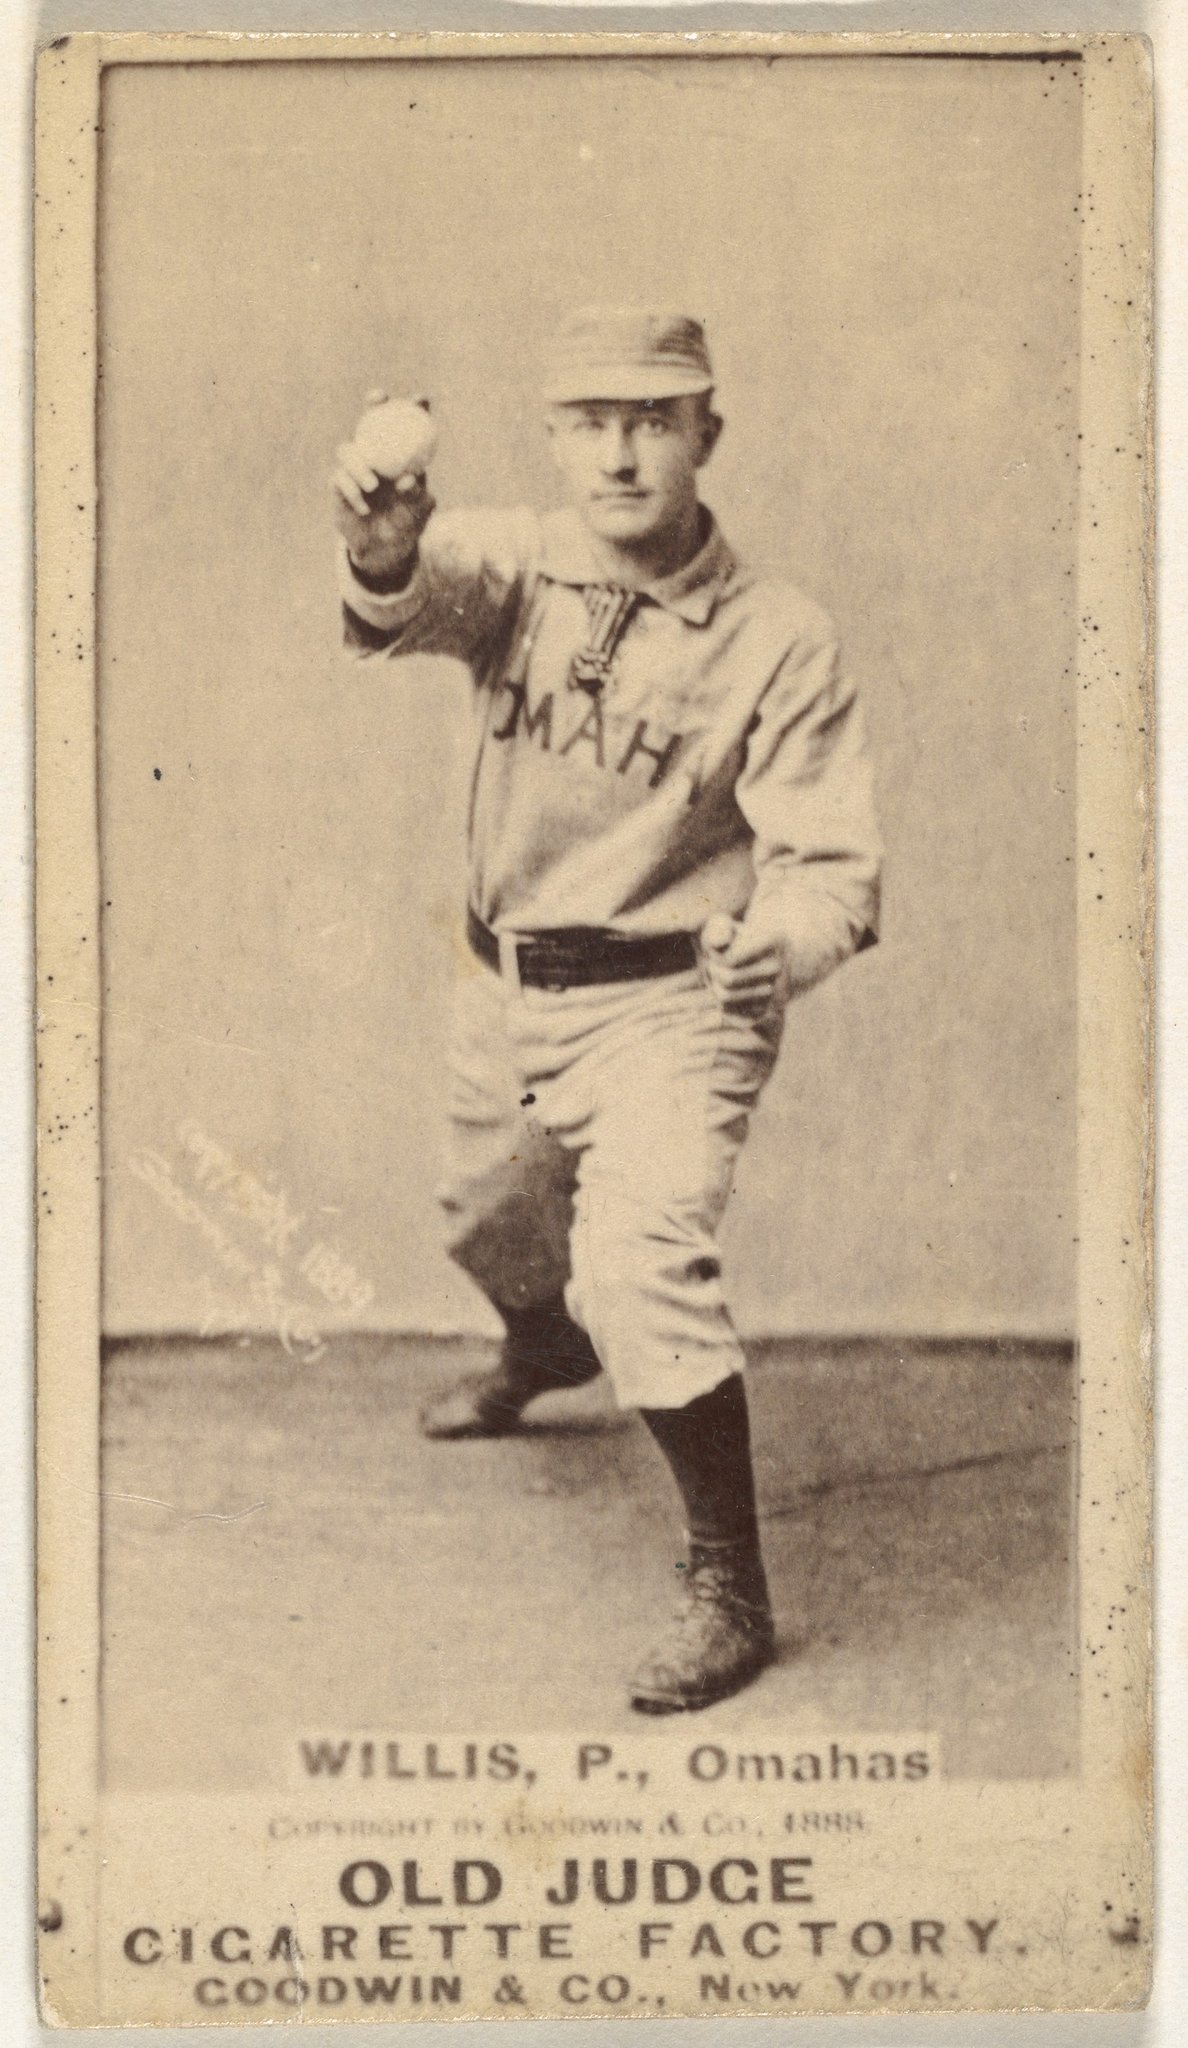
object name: baseball card, photograph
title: Willis, Pitcher, Omaha Omahogs/ Lambs, from the Old Judge series (N172) for Old Judge Cigarettes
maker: goodwin & company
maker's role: publisher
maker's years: 1850-1950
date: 1888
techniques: albumen silver print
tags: men,portraits,baseball,athletes